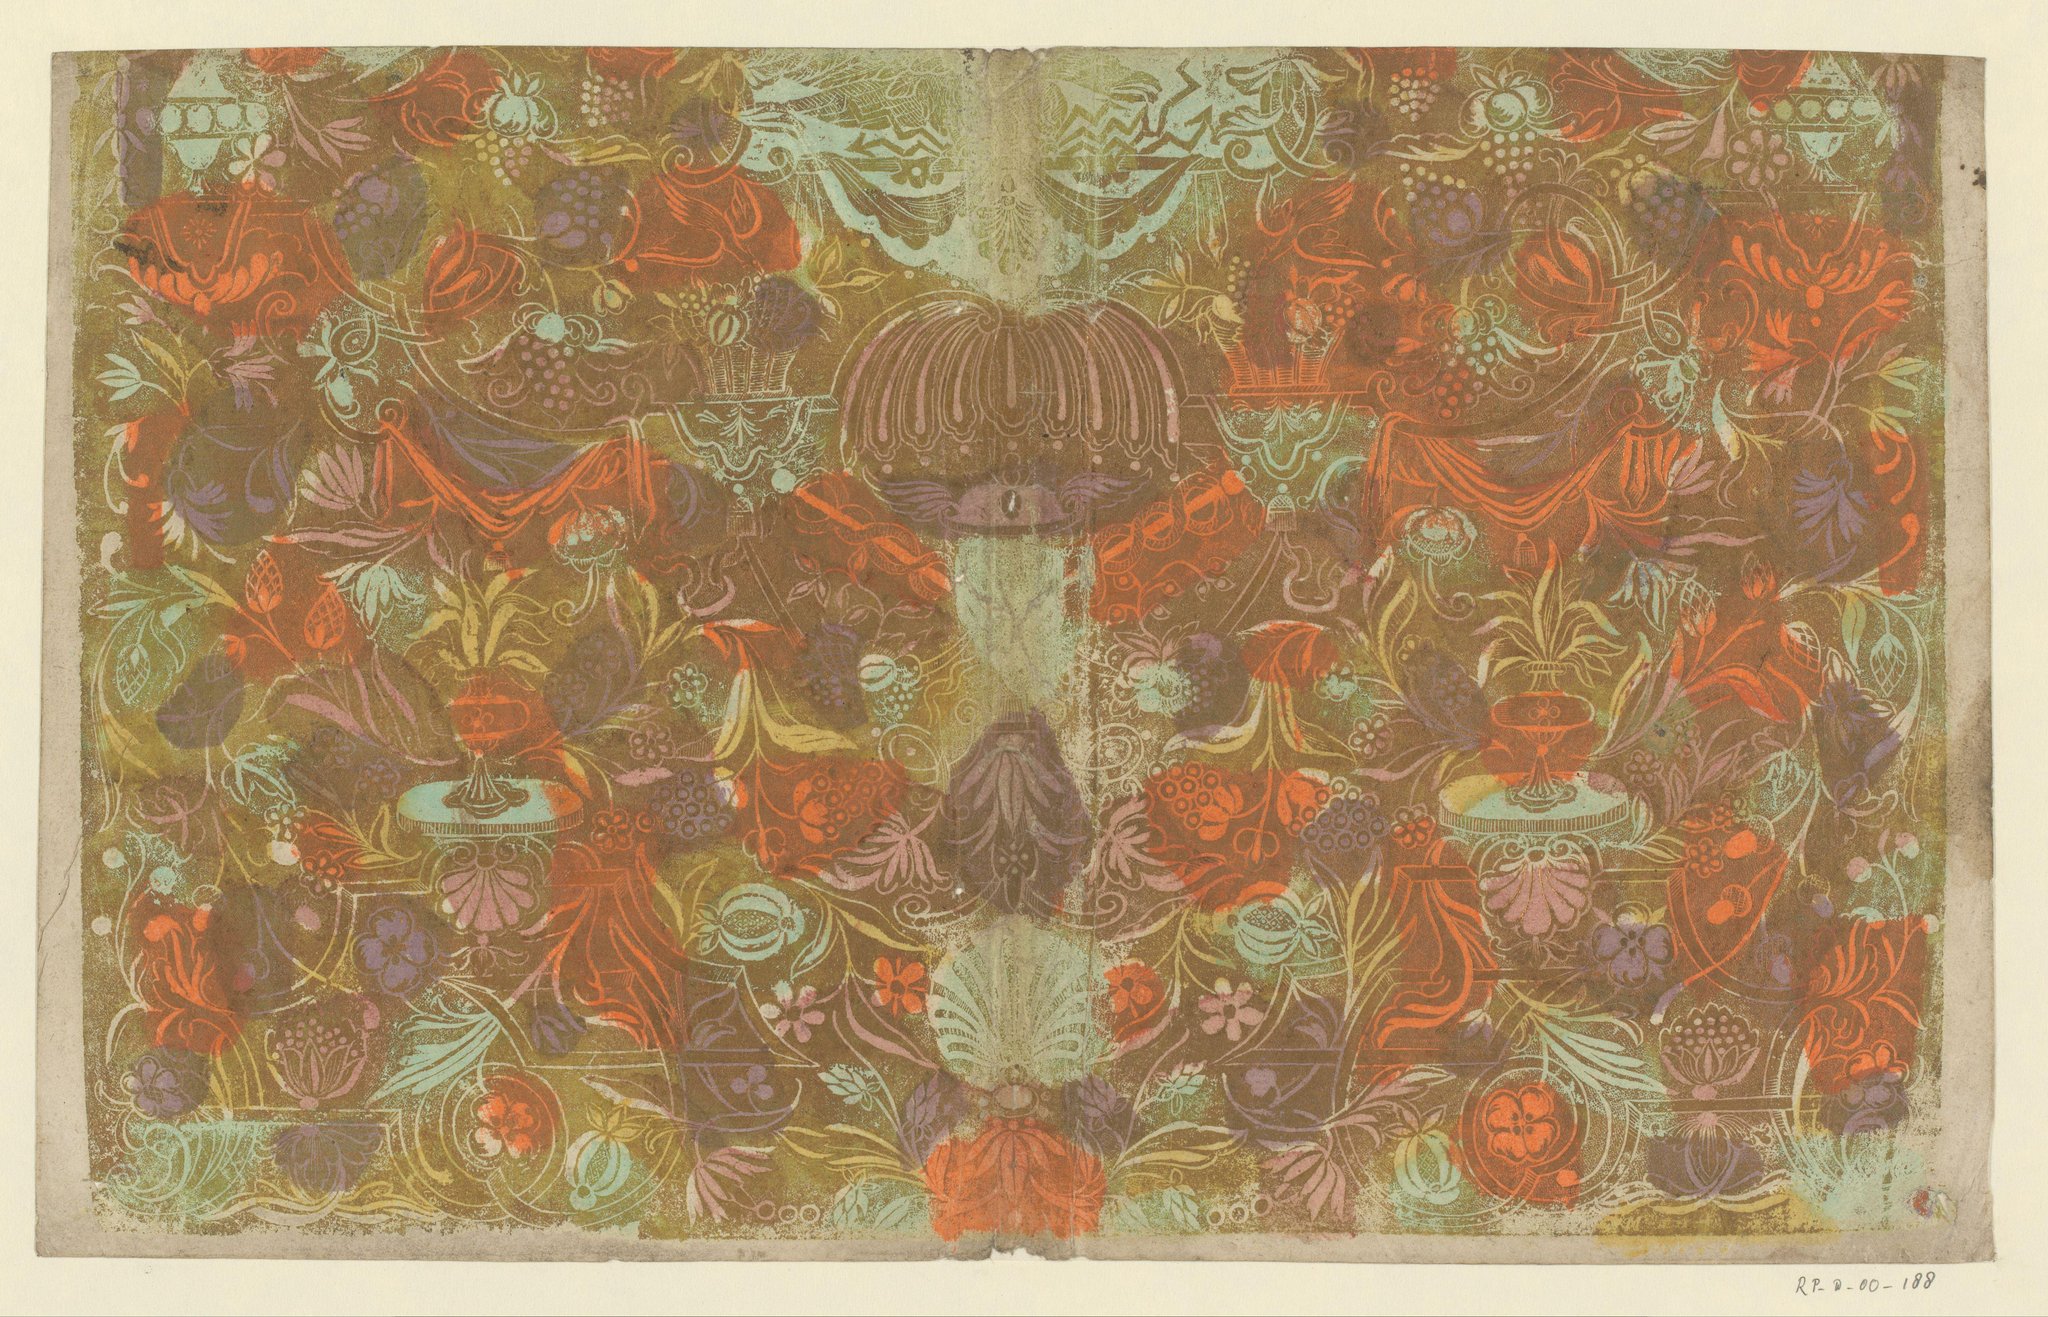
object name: brocade paper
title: Blad met Lodewijk XIV-ornamenten van bloemen en vruchten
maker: Anonymous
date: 1750-1800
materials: gold leaf, paint, paper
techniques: relief print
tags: caduceus (staff with two snakes, attribute of mercury), ornament derived from plant forms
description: Blad, gebruikt als omslag, met Lodewijk XIV-ornamenten van bloemen en vruchten. Twee identieke spiegelbeeldige helften met rechts en links in het midden een kelk op een tafel, daarboven een vruchtenmand. Centraal bovenaan het blad een adelaar met bliksemschichten, daar onder een baldakijn en gekruiste Mercuriusstaven.